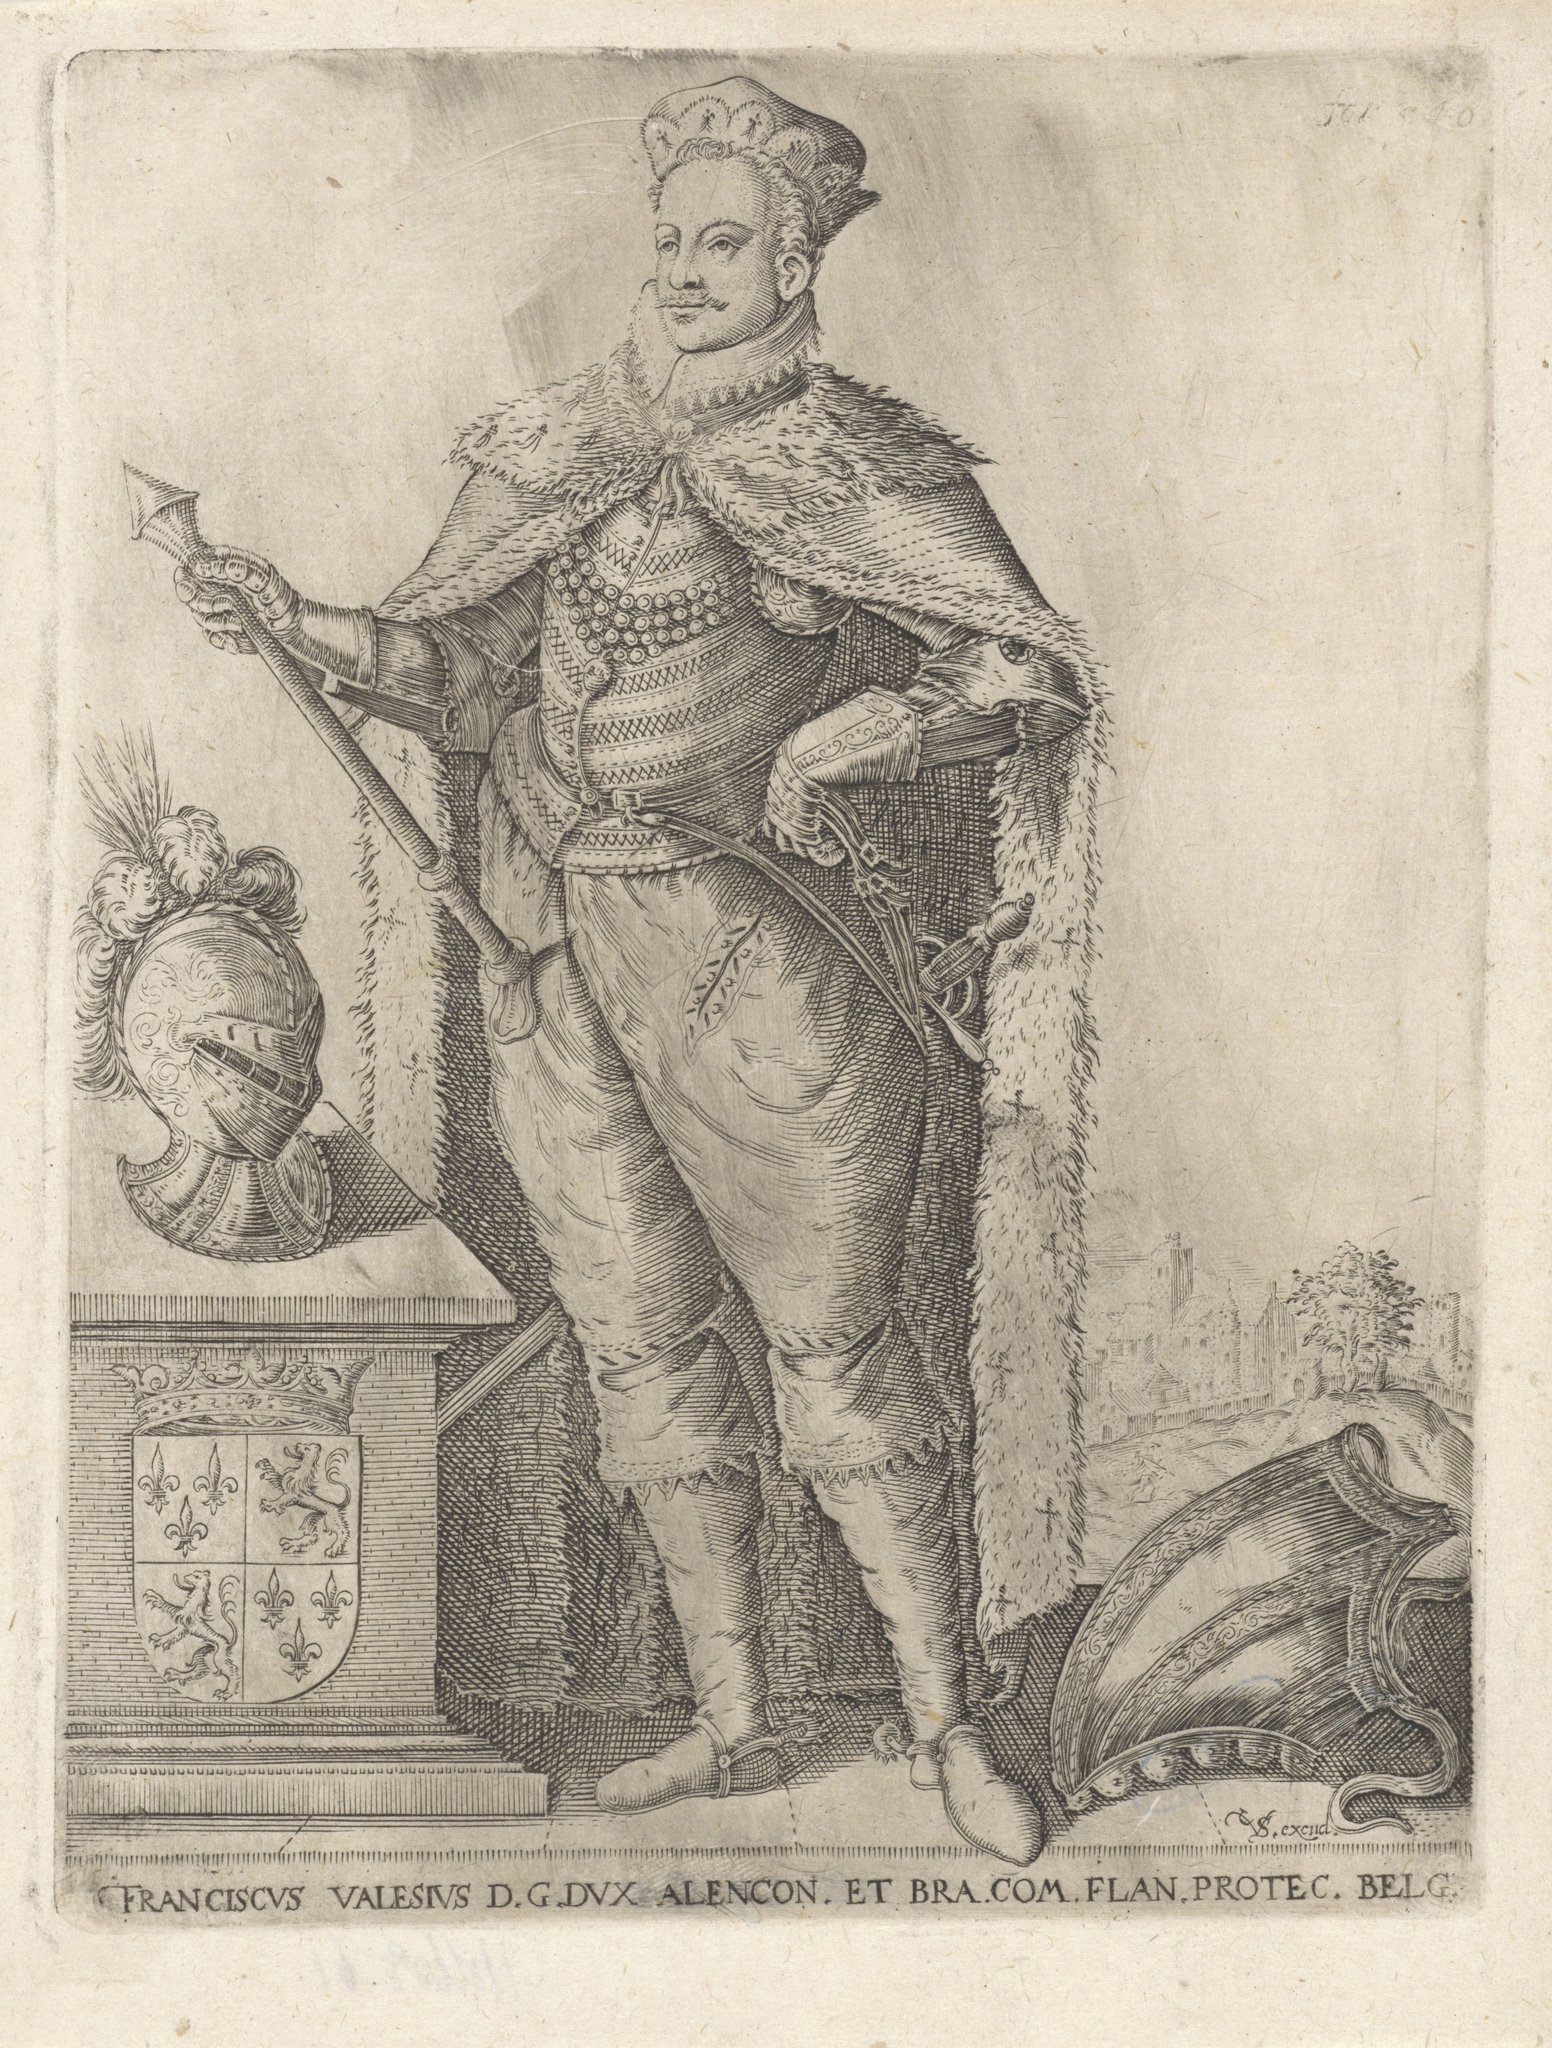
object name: book illustration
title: Portret van François-Hercule de Valois, hertog van Anjou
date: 1626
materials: paper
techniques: engraving, etching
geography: arnhem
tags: paris, françois-hercule de valois (hertog van anjou)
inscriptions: collector's mark: Lugt 964, collector's mark: Lugt 2228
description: Portret van François-Hercule de Valois, hertog van Anjou. Hij draagt een lange met bont gevoerde mantel en houdt een commando-staf in de hand. Op een voetstuk naast hem, met daarop zijn wapenschild, ligt een helm van een harnas. Op de grond ligt een schild. Op de achtergrond een landschap.